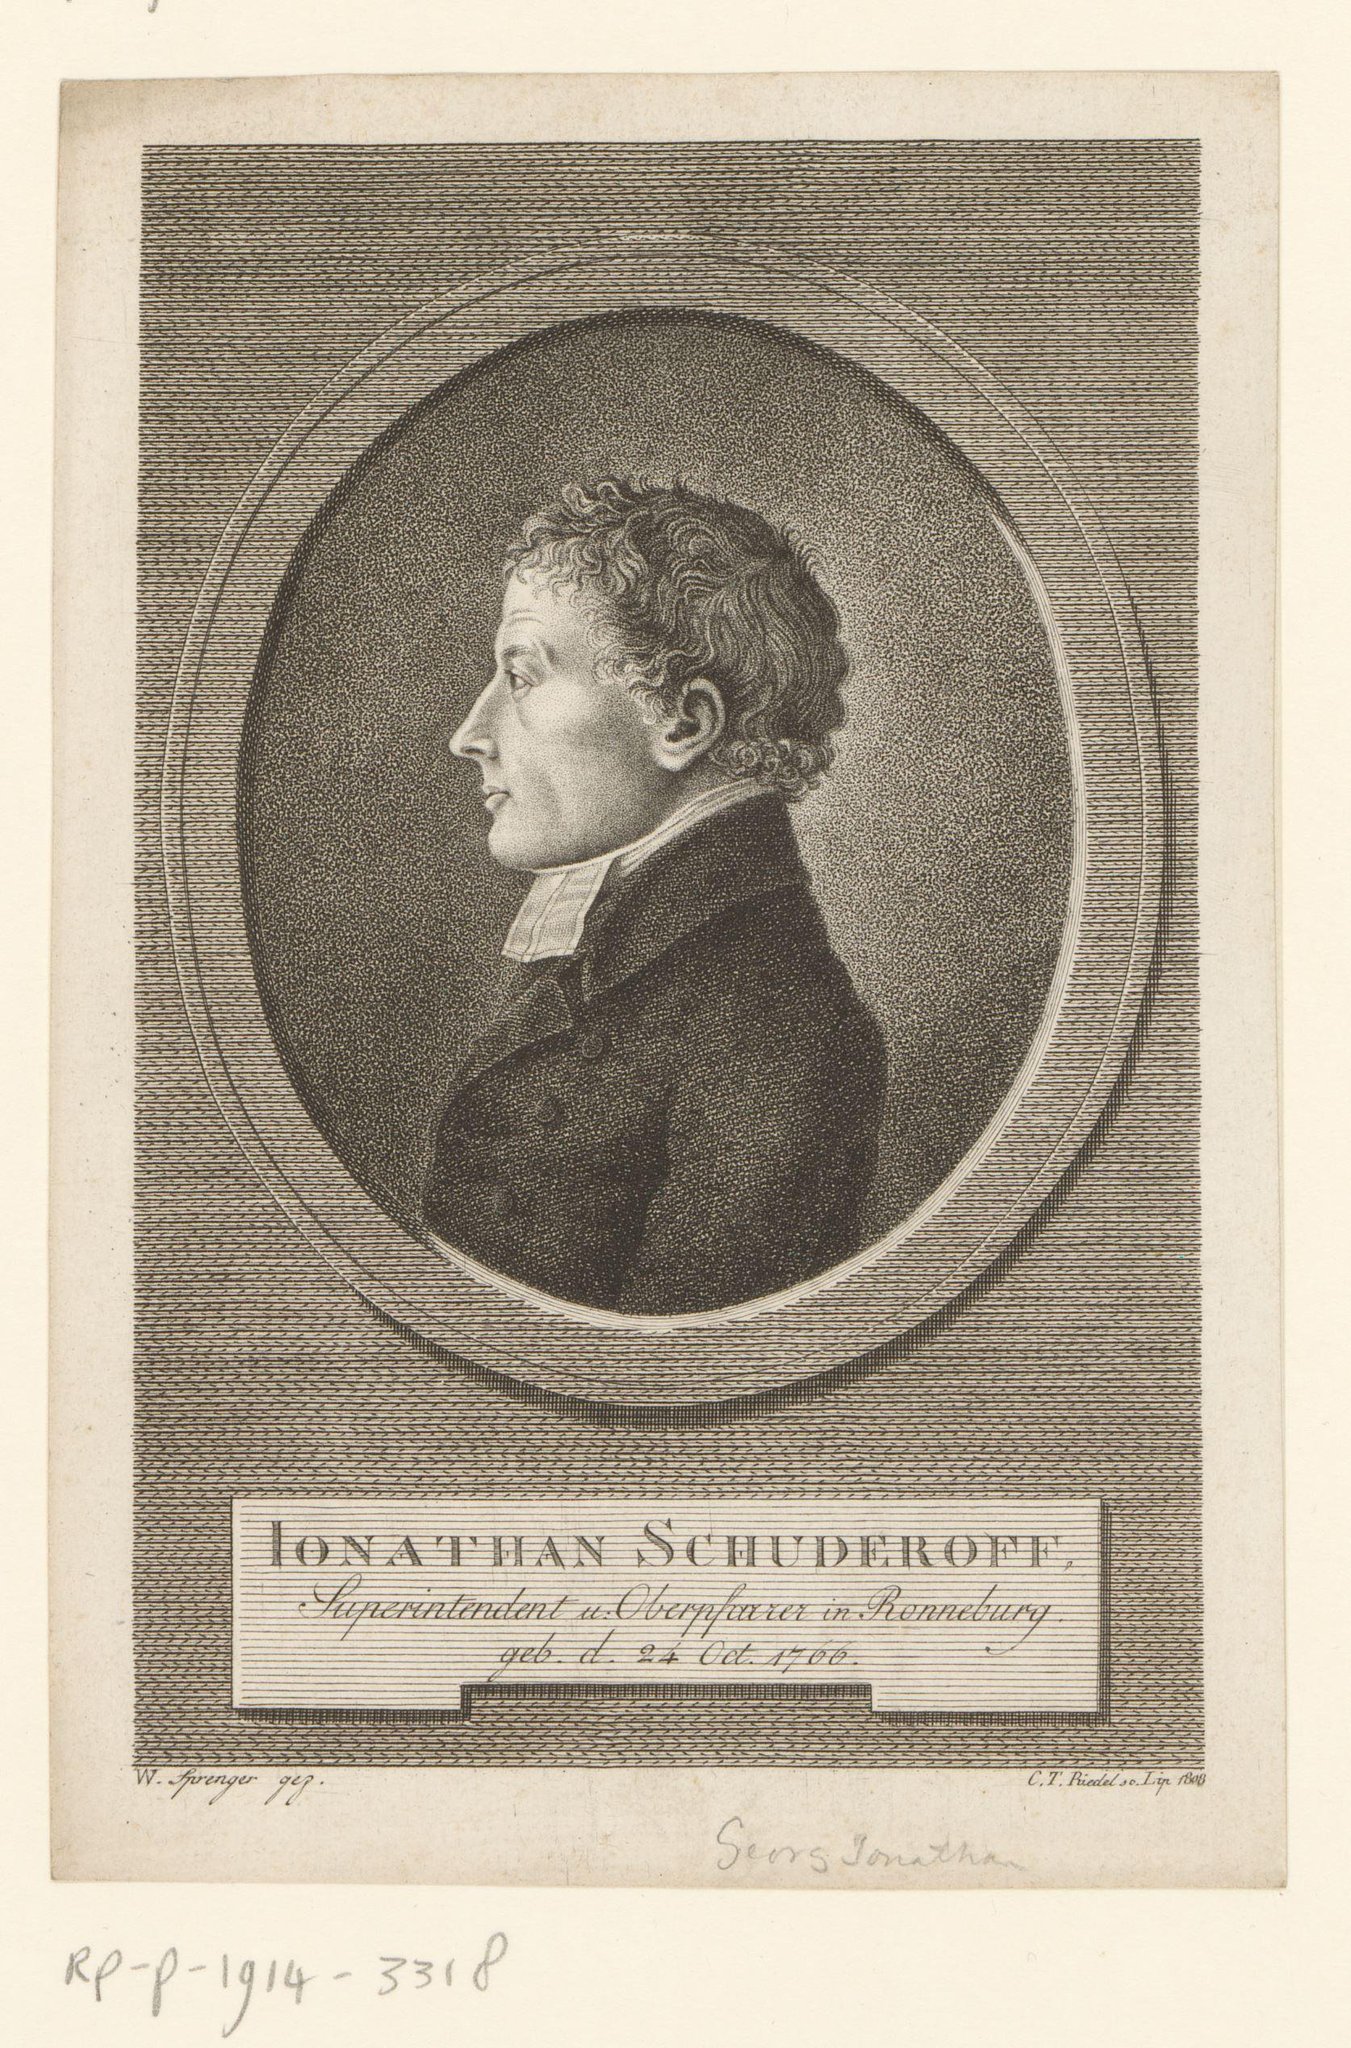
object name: print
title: Portret van Jonathan Schuderoff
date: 1808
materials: paper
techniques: engraving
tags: theologian, historical persons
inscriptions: collector's mark: Lugt 2228